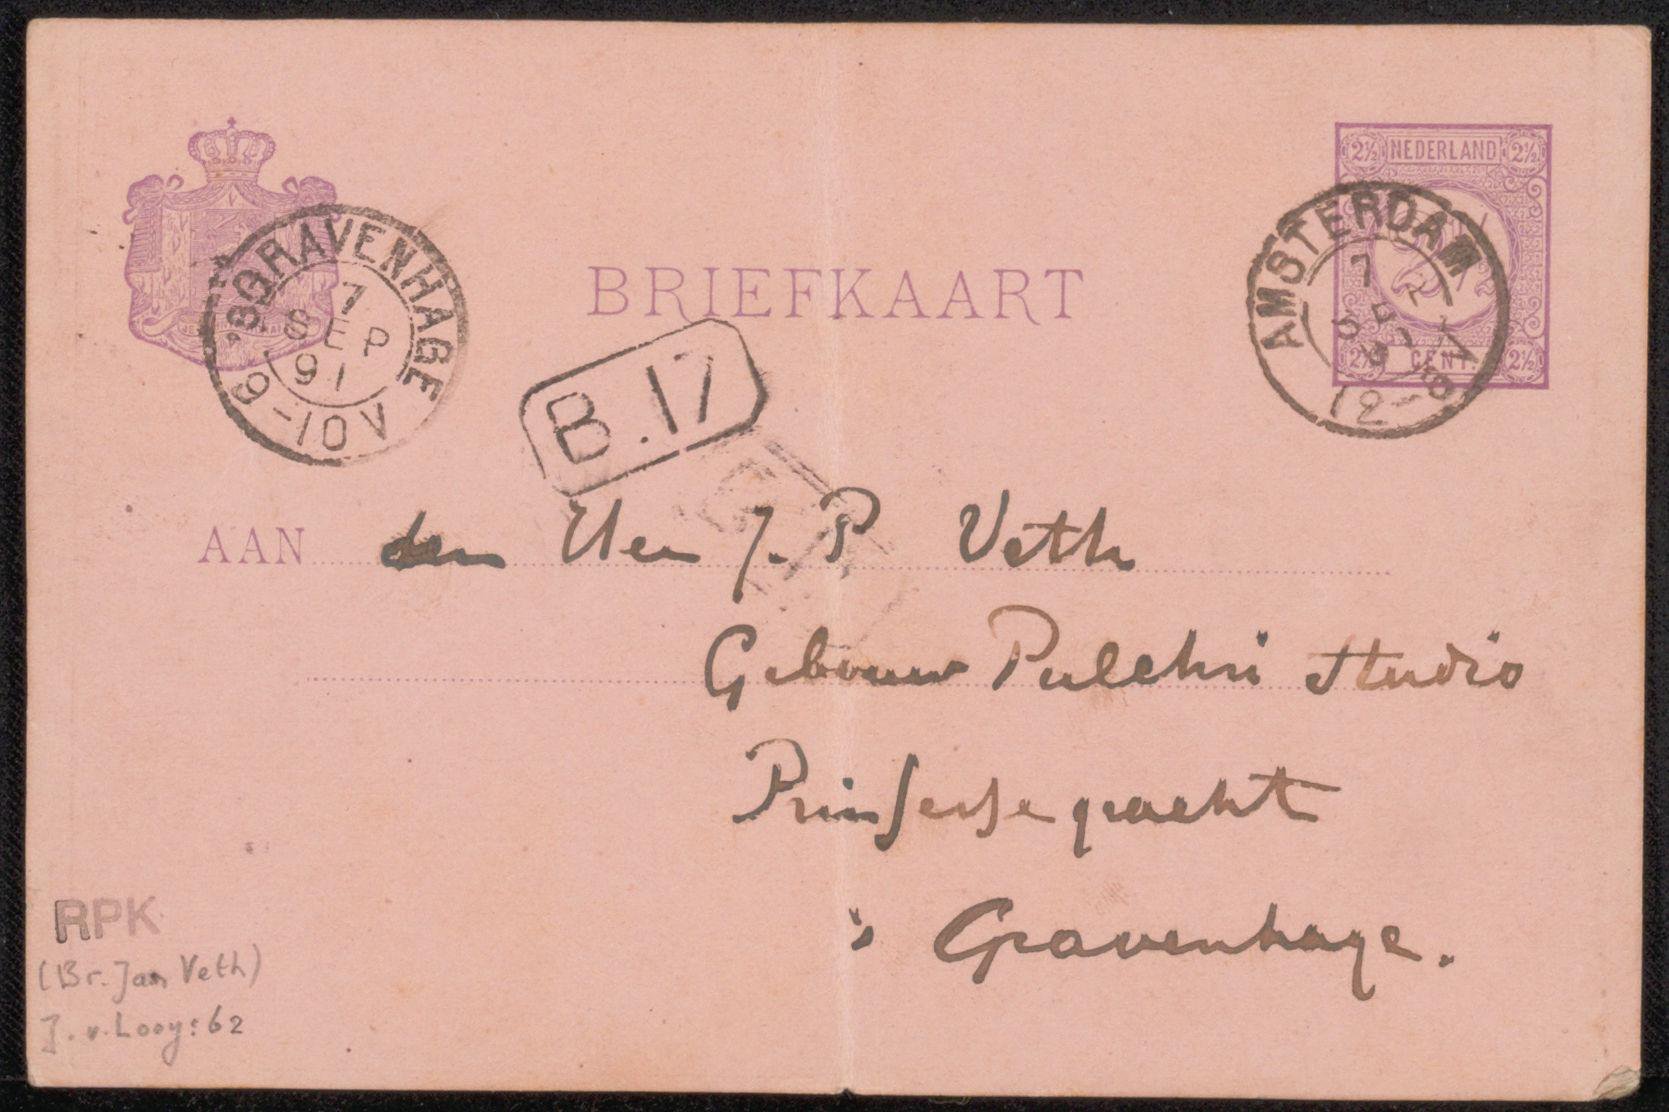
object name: postcard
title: Briefkaart aan Jan Veth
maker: jac van looij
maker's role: draughtsman, painter, print maker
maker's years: 1855-1930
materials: cardboard, ink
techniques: pen, writing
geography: amsterdam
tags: dordrecht, amsterdam, painter, print maker, draughtsman, designer, jan veth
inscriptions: collector's mark: ‘RPK’